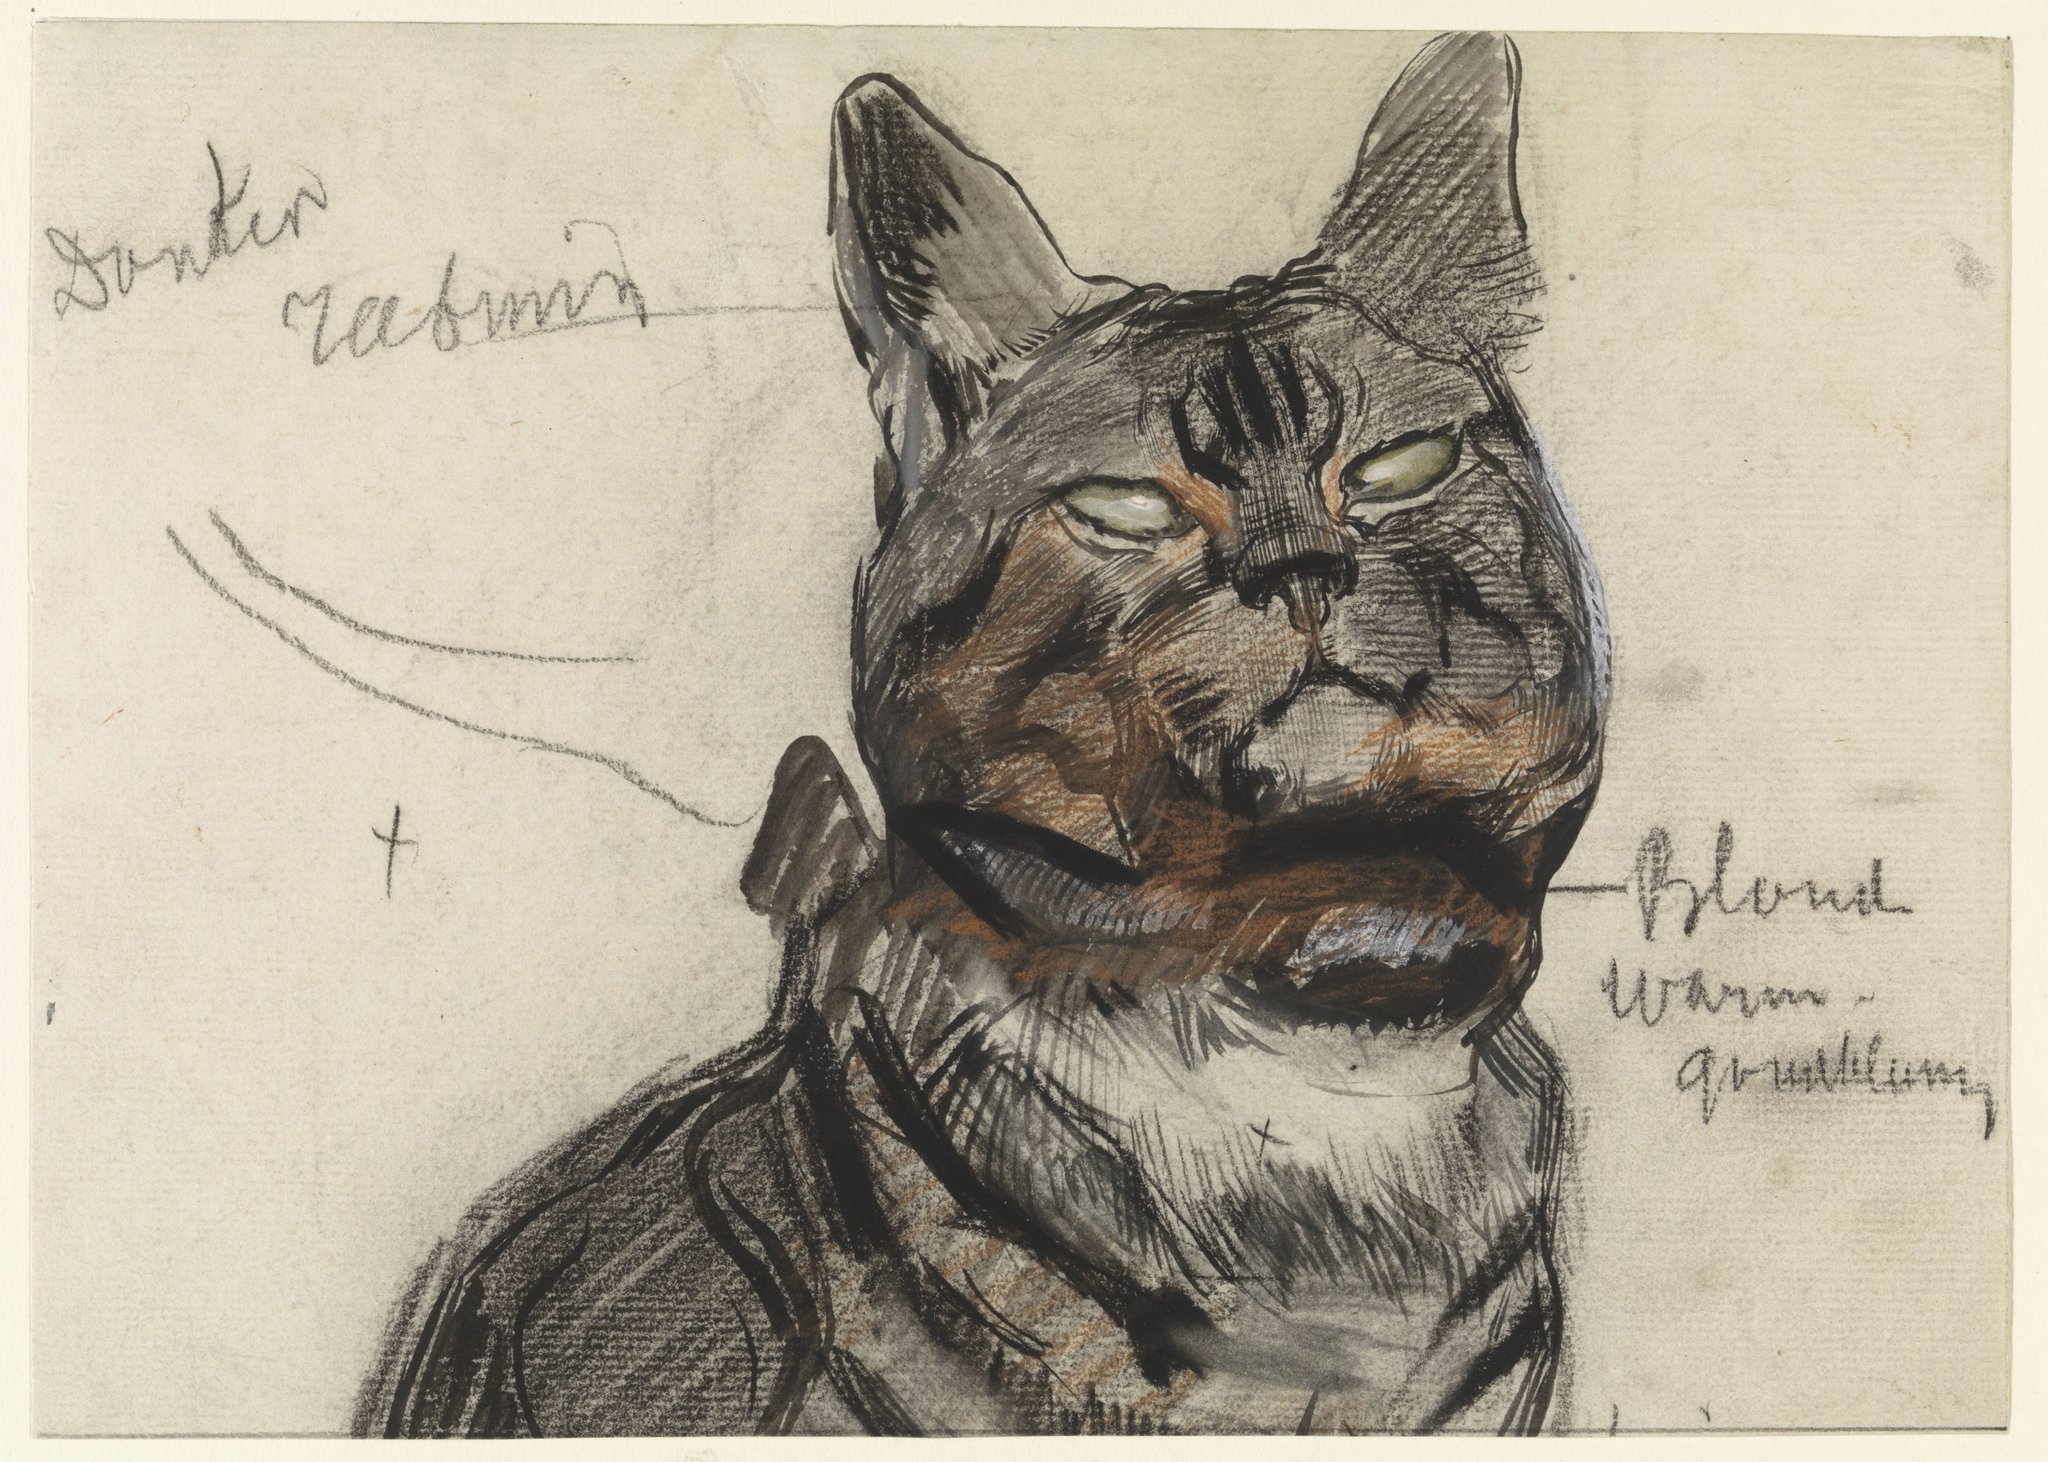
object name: drawing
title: Kat, met kleurnotities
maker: jan van essen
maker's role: draughtsman, print maker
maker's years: 1854-1936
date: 1864-1936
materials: chalk, paper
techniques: brush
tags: cat